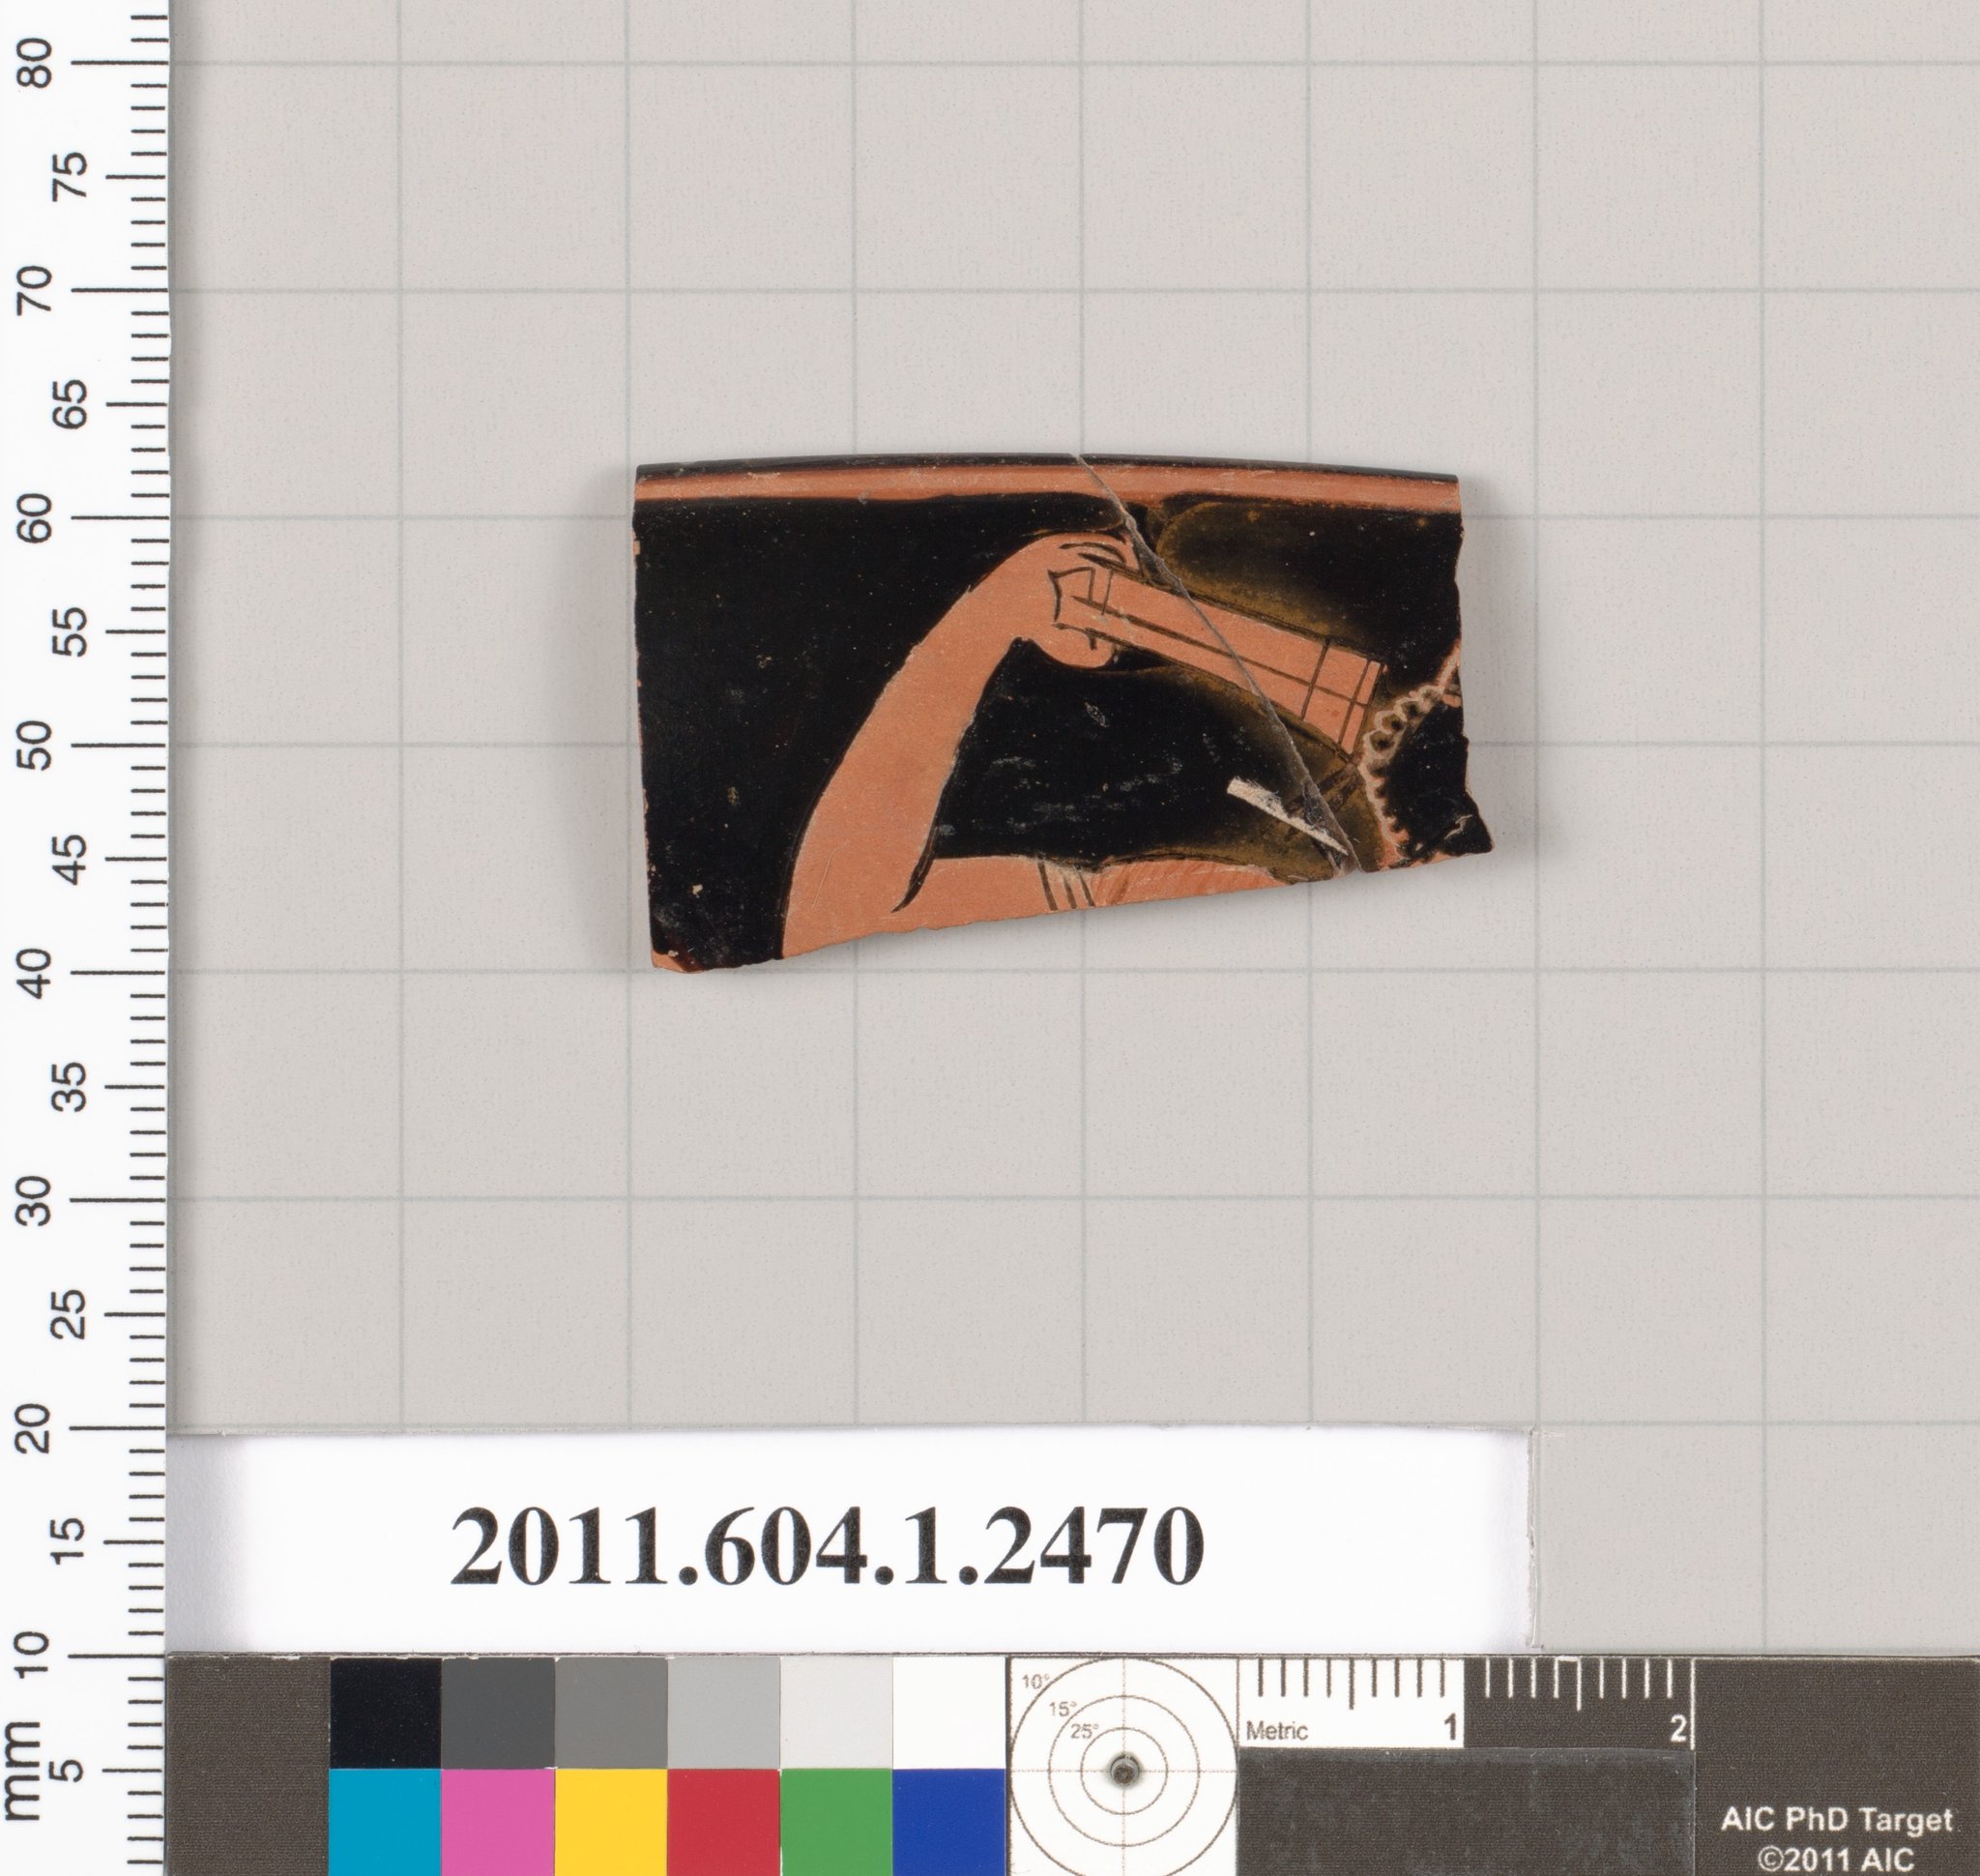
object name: kylix fragment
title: Terracotta rim fragment of a kylix (drinking cup)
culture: greek, attic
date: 500-490 BCE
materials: terracotta